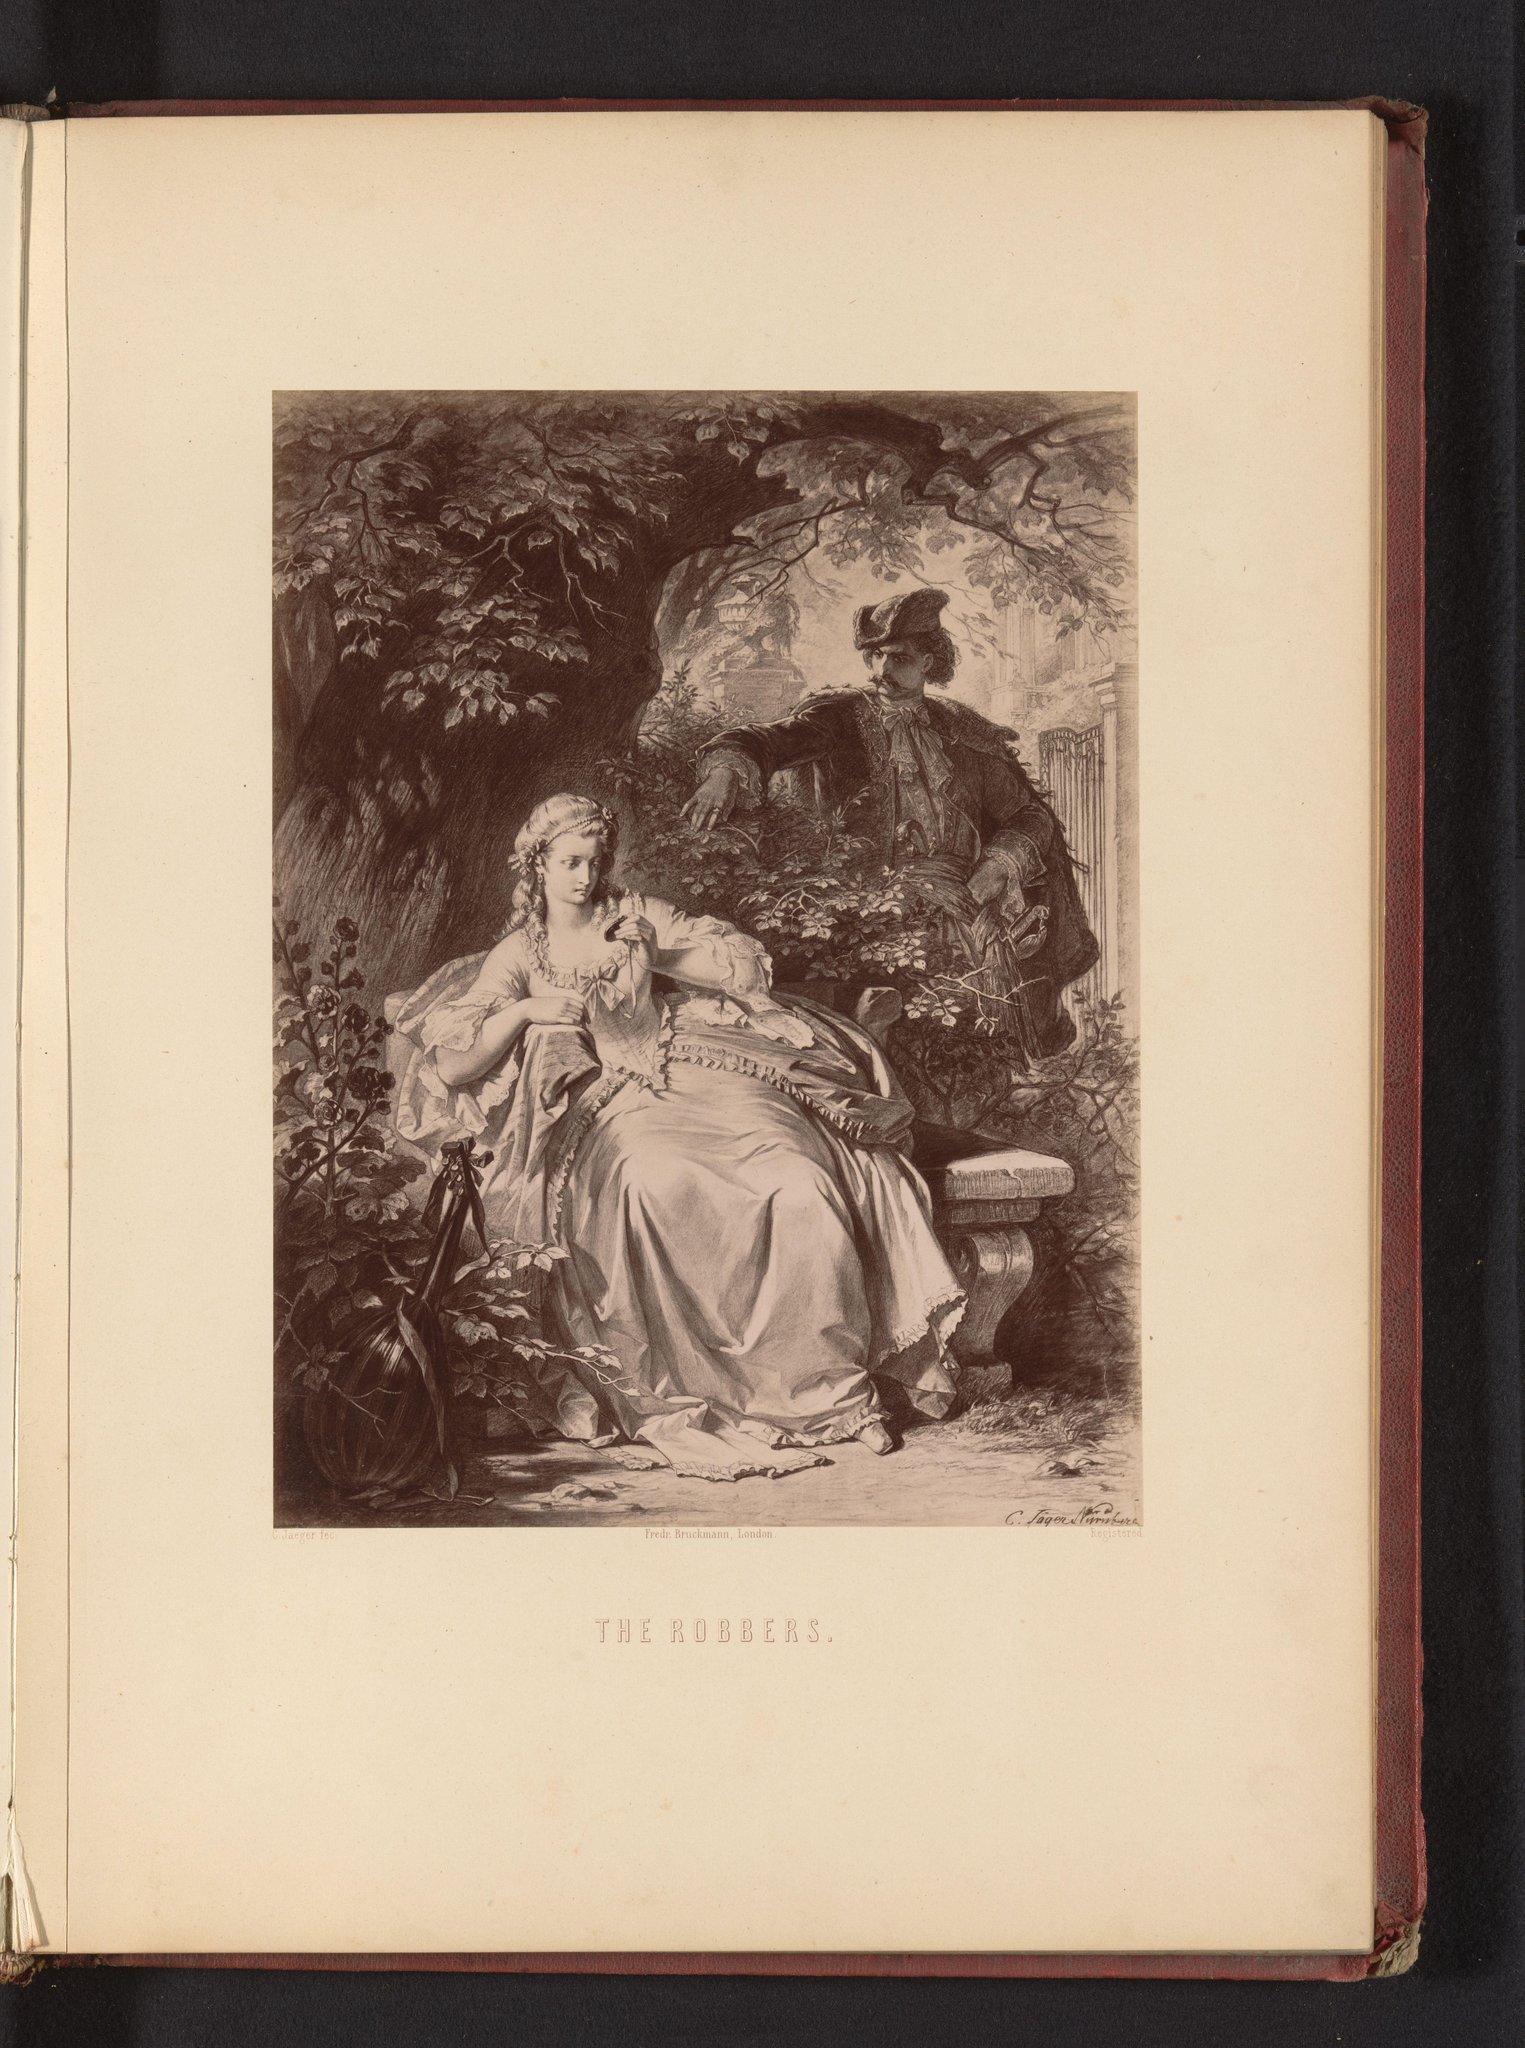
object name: photograph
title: The Robbers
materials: photographic support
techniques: albumen print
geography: london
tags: robbery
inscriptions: inscription: ‘Registered.’